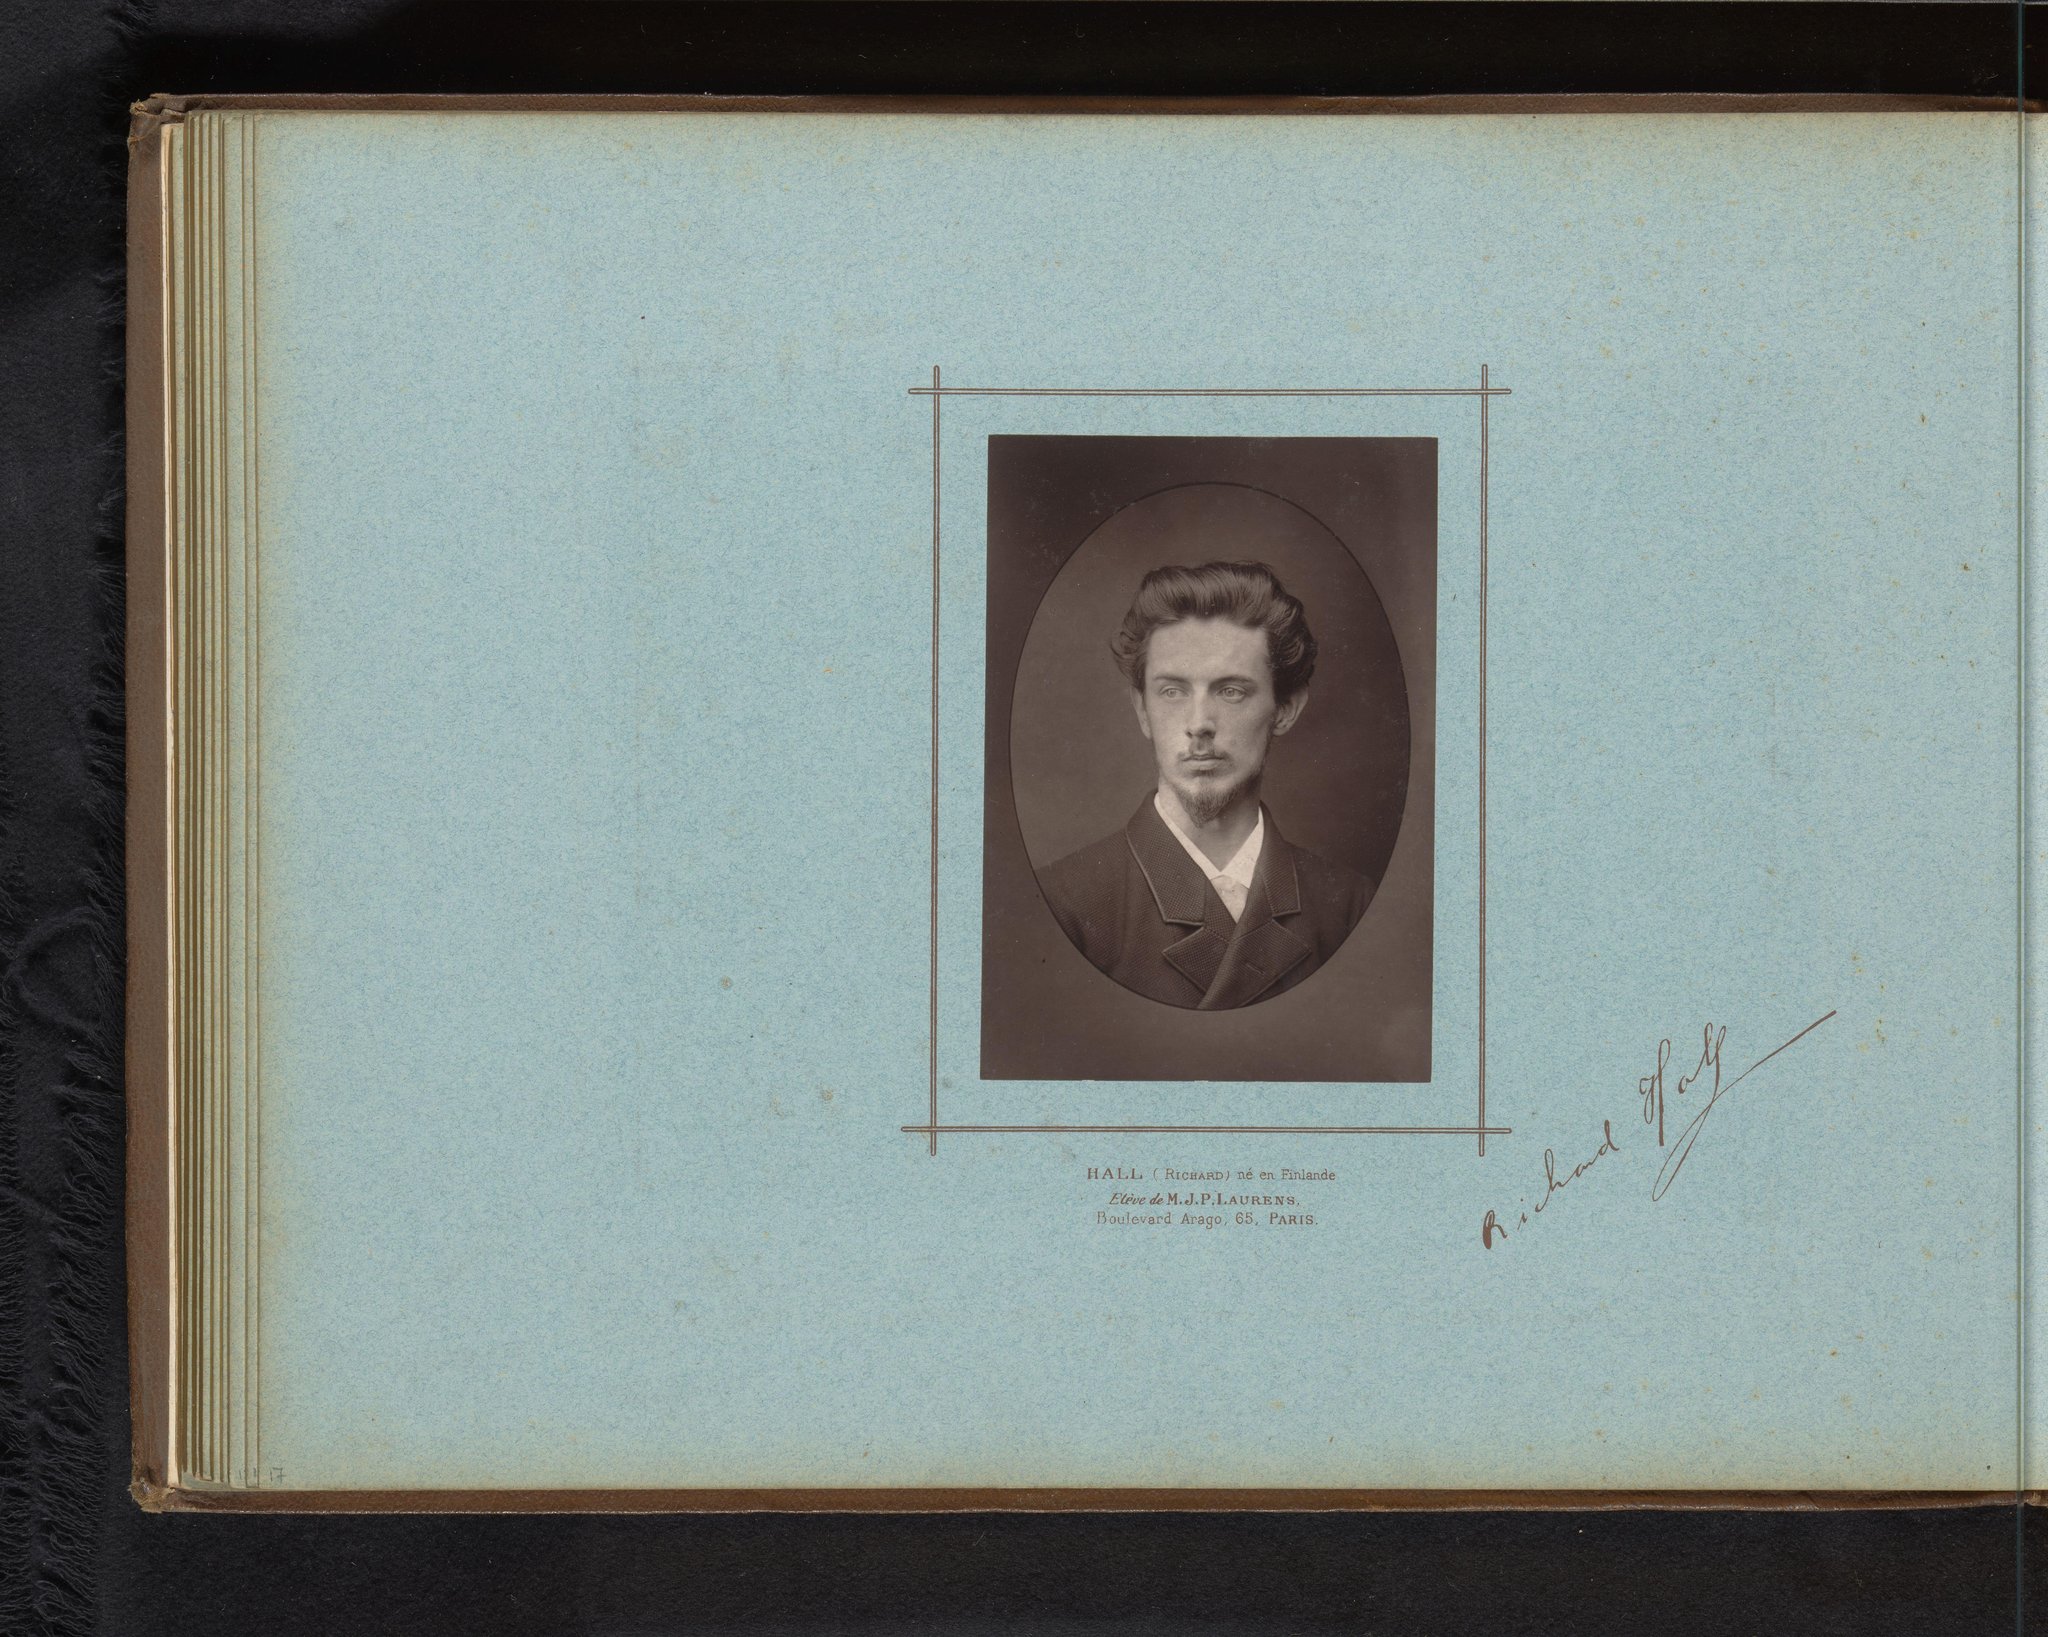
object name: photomechanical print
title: Portret van Richard Hall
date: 1879-1884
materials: paper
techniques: woodburytype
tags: painter, richard hall, historical persons, portrait, self-portrait of painter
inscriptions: inscription: ‘HALL (Richard) né en Finlande/ Elève de M.J.P. Laurens./ Boulevard Arago, 65, Paris.’, signature: ‘Richard Hall’